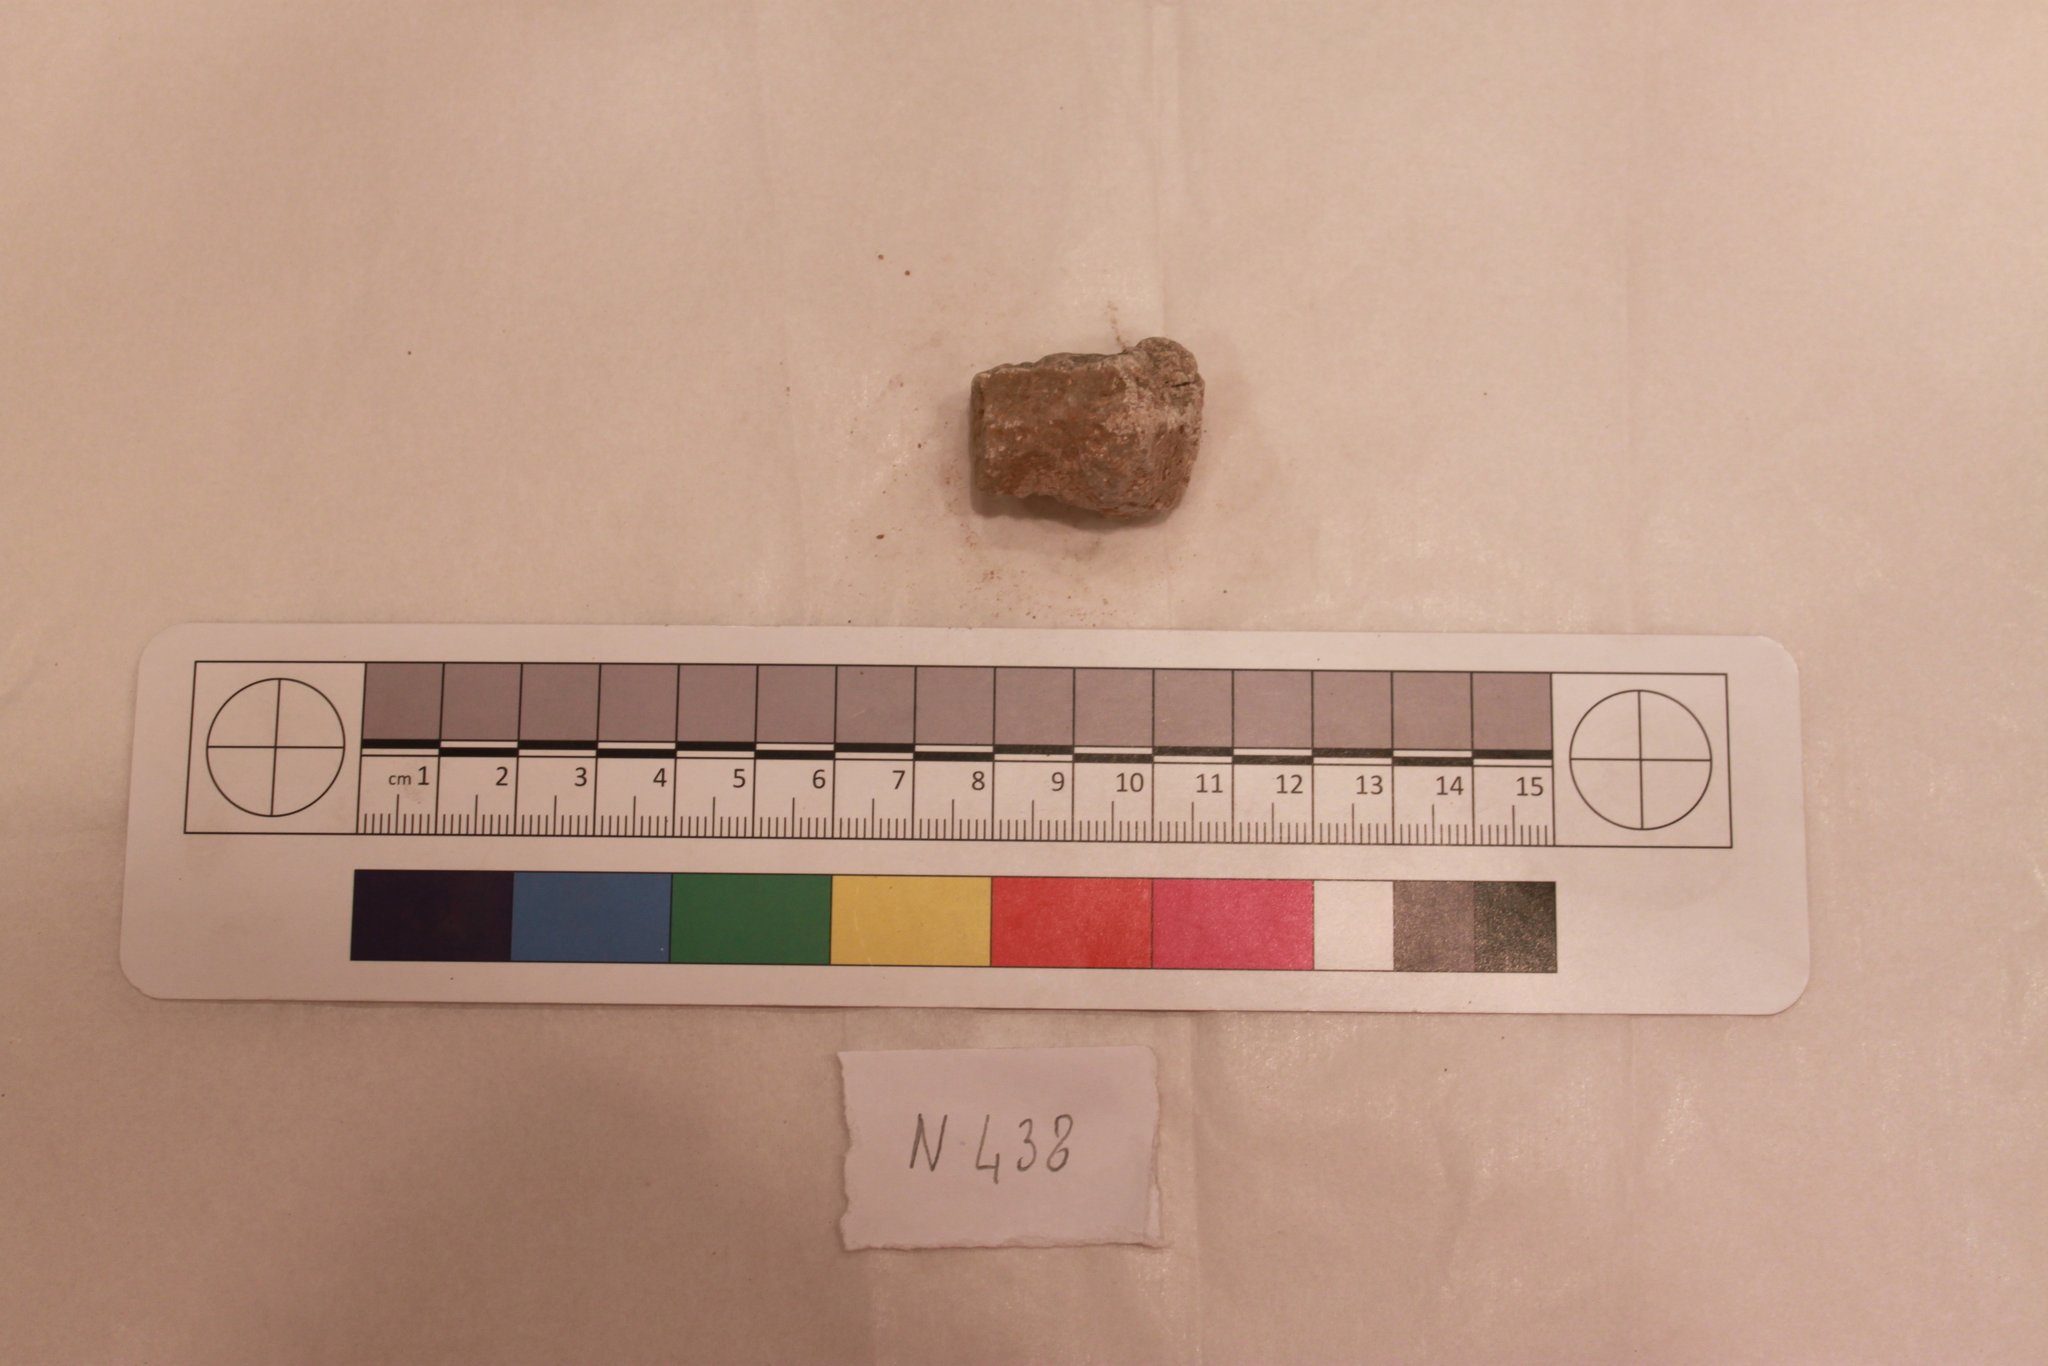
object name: fragment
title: Stucco Fragment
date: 701-1200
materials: plaster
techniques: carving, painting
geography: iran